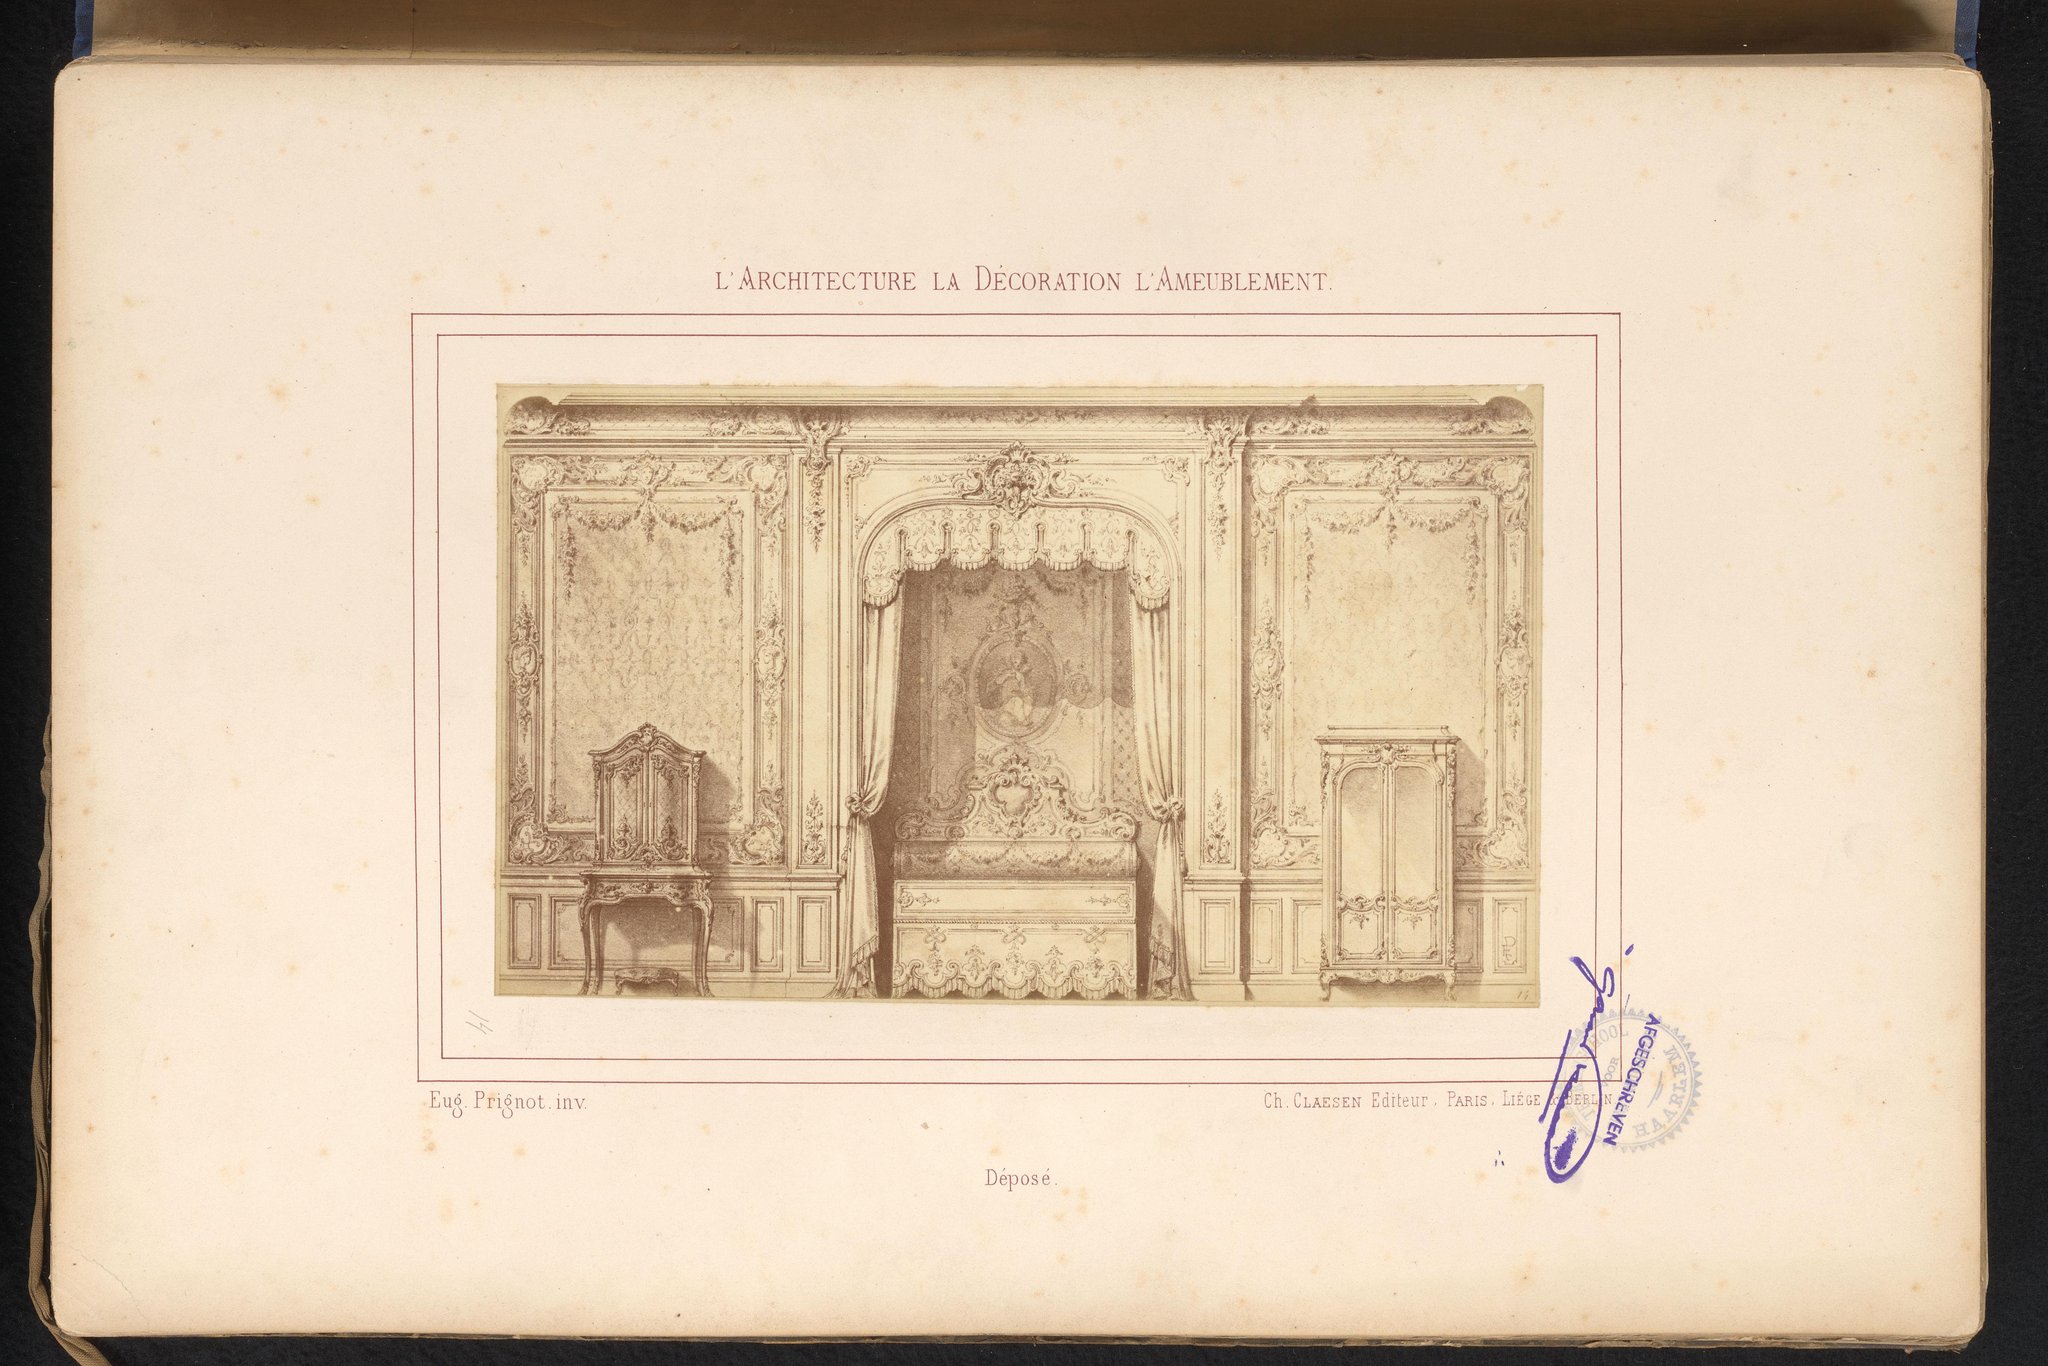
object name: photograph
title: L'Architecture la Décoration l'Ameublement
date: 1873-1880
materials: cardboard, paper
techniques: albumen print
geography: liège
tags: ornamental cupboard, bed, wall-covering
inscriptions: number: ‘14’, stamp: ‘TEEKENSCHOOL/ VOOR/ KUNSTNIJVERHEID/ HAARLEM’, stamp: ‘AFGESCHREVEN/ [...]’, inscription: ‘Eug. Prignot. inv.’, inscription: ‘Déposé’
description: Deze foto maakt deel uit van een omslag met 61 foto's op 61 bladen.